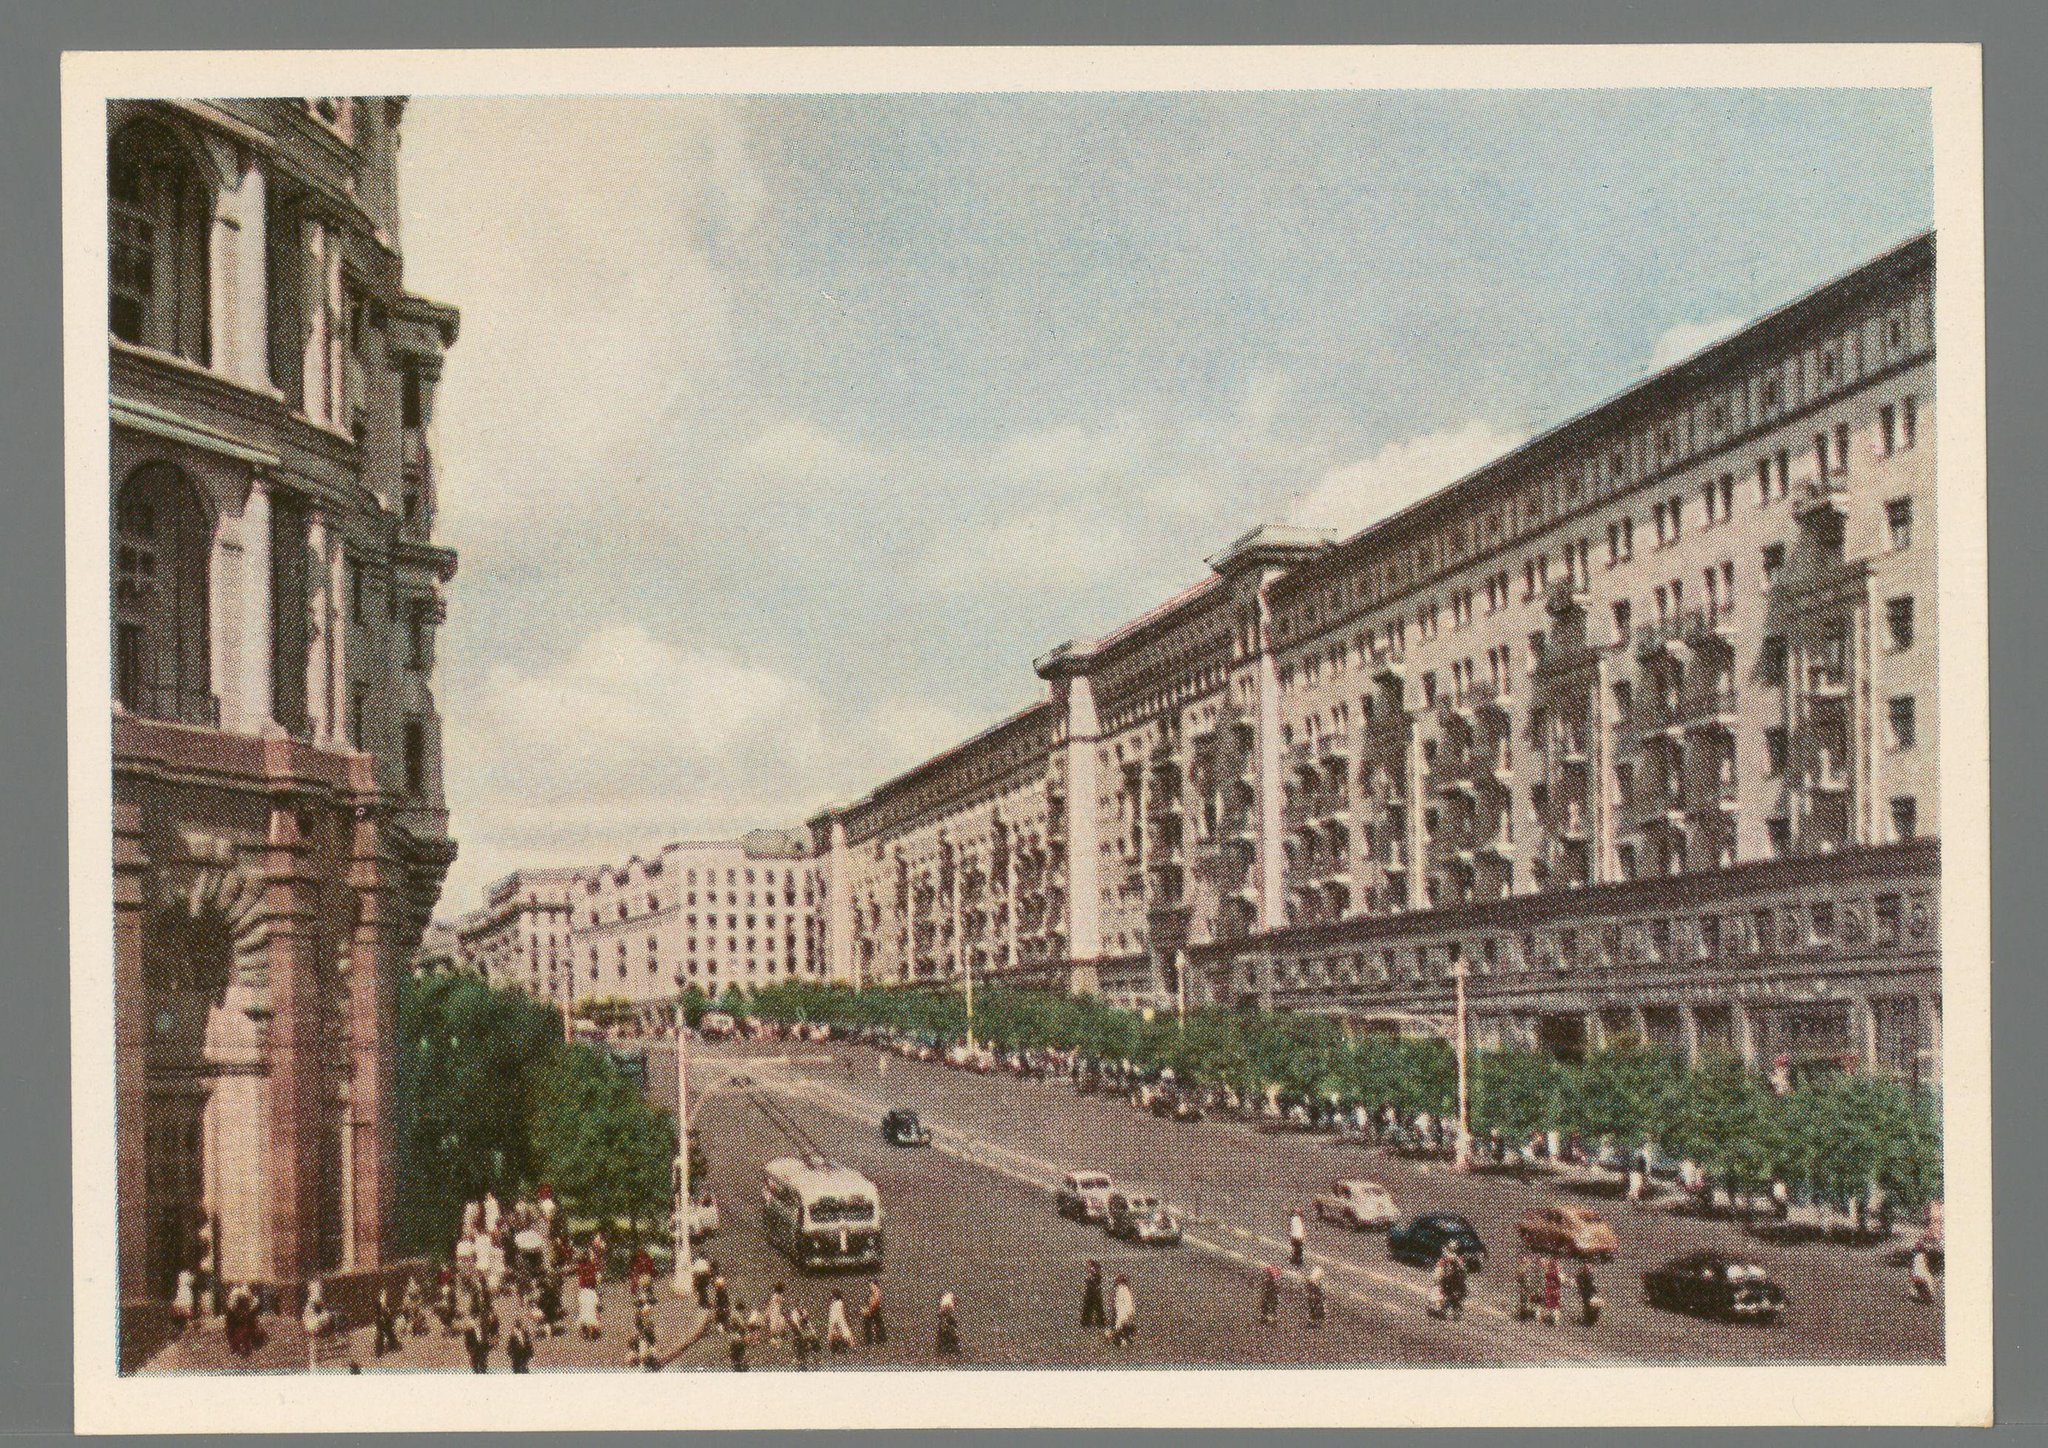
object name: ansichtkaart, prentbriefkaart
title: Moscow. Gorky Street / Moskau. Gorki-Straβe / Moscou. Rue Gorki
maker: Anonymous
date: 1956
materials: cardboard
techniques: color autotype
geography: moscow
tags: street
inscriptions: date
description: De titel op object staat ook in het Russisch.